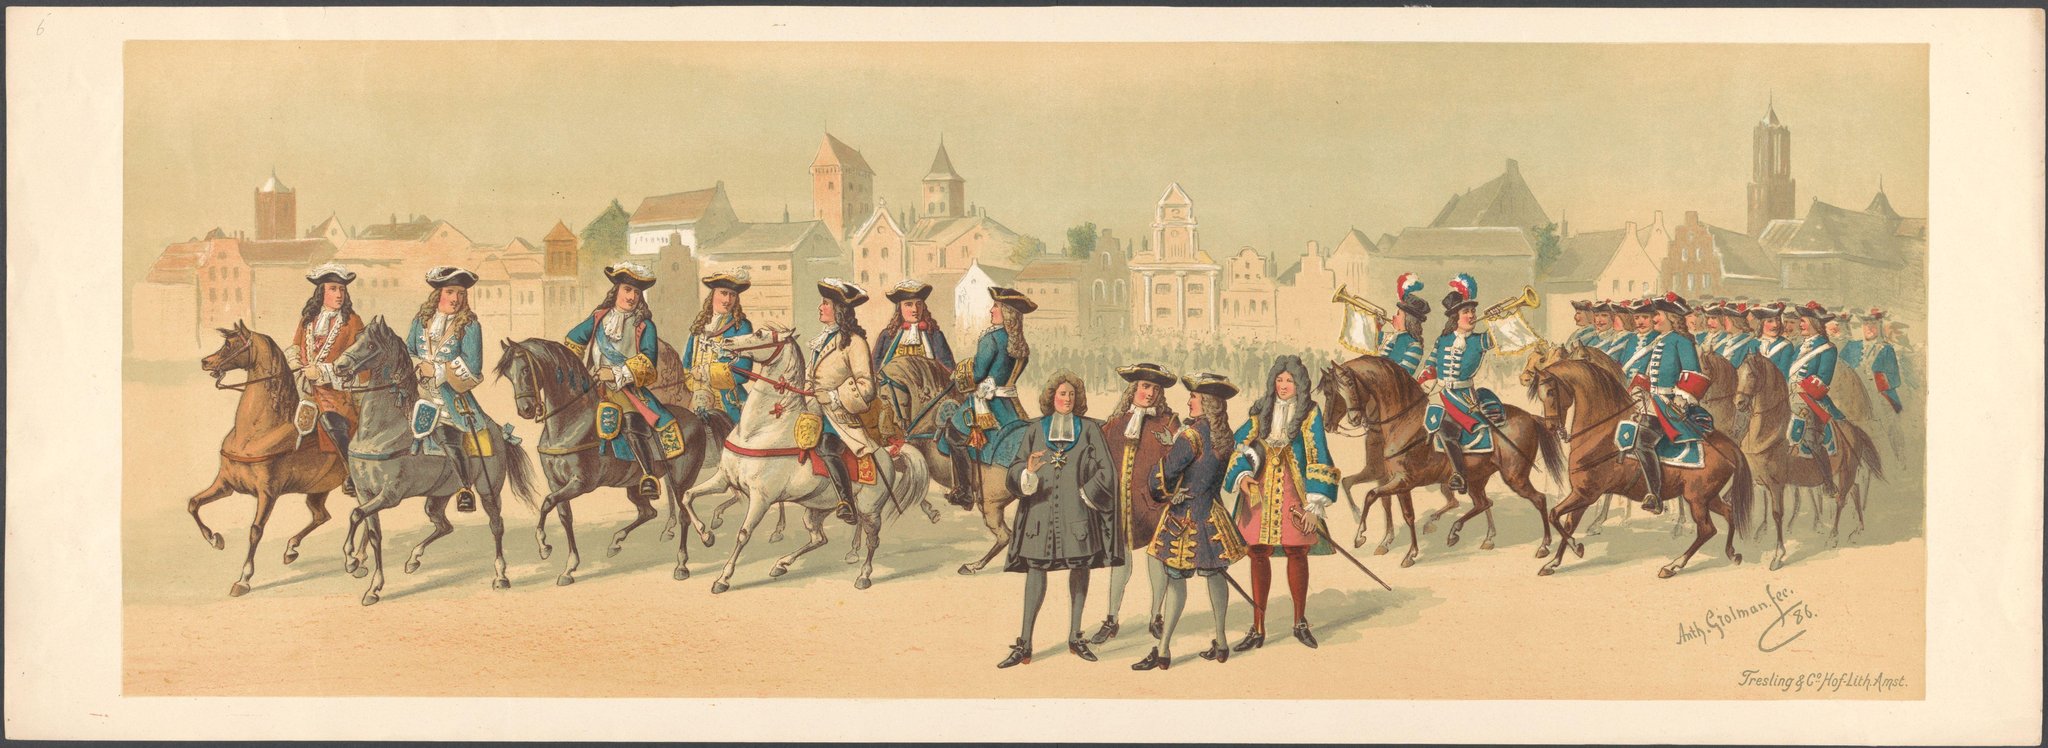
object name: print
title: Utrechtse maskerade van 1886 (zesde plaat)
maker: anthony grolman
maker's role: draughtsman, print maker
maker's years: 1843-1926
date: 1886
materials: paper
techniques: chromolithography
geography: amsterdam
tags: students' pageant, costumes used in pageants, commemoration of the founding of a university, utrecht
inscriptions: collector's mark: Lugt 2228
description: Vrede van Utrecht in 1713. Zesde plaat in de serie van zes platen plus titelprent en verklaring van de historische optocht gehouden door de studenten van de Utrechtse Hogeschool op 22 juni 1886 ter gelegenheid van haar 250-jarige bestaan. De gekostumeerde optocht stelt voor I: de Unie van Utrecht, II: de stichting van de Hogeschool en III: de Vrede van Utrecht.